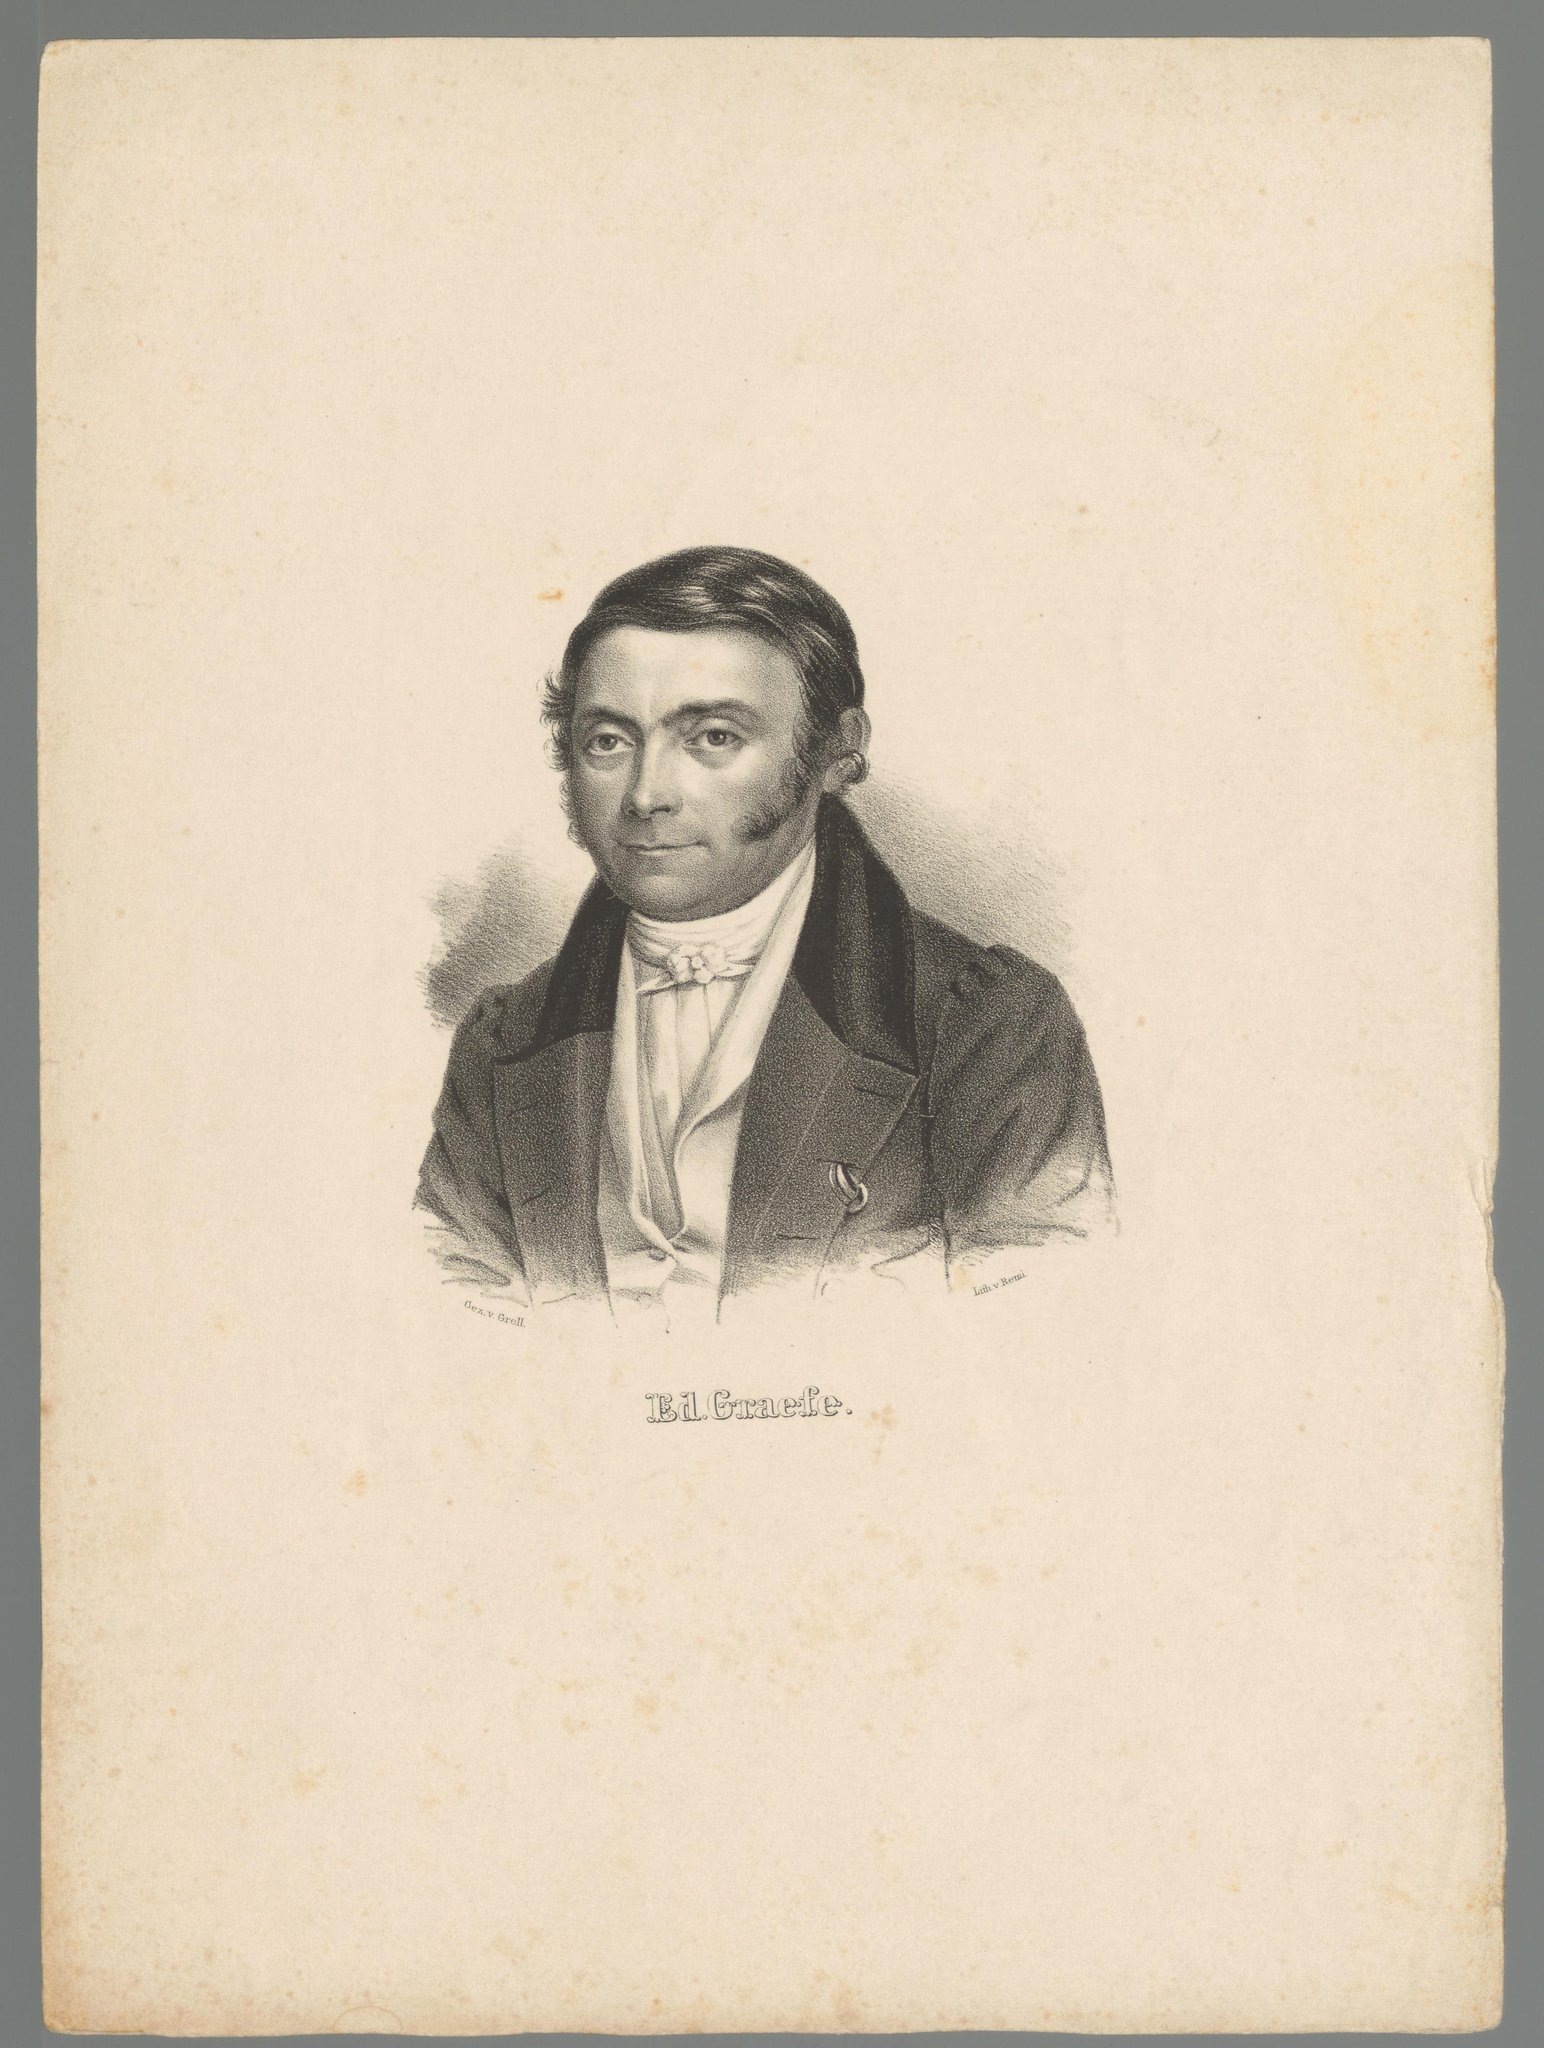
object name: print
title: Portret van Karl Ferdinand von Gräfe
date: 1800-1850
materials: paper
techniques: lithograph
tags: karl ferdinand von gräfe, adult man, historical persons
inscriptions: collector's mark: Lugt 2228